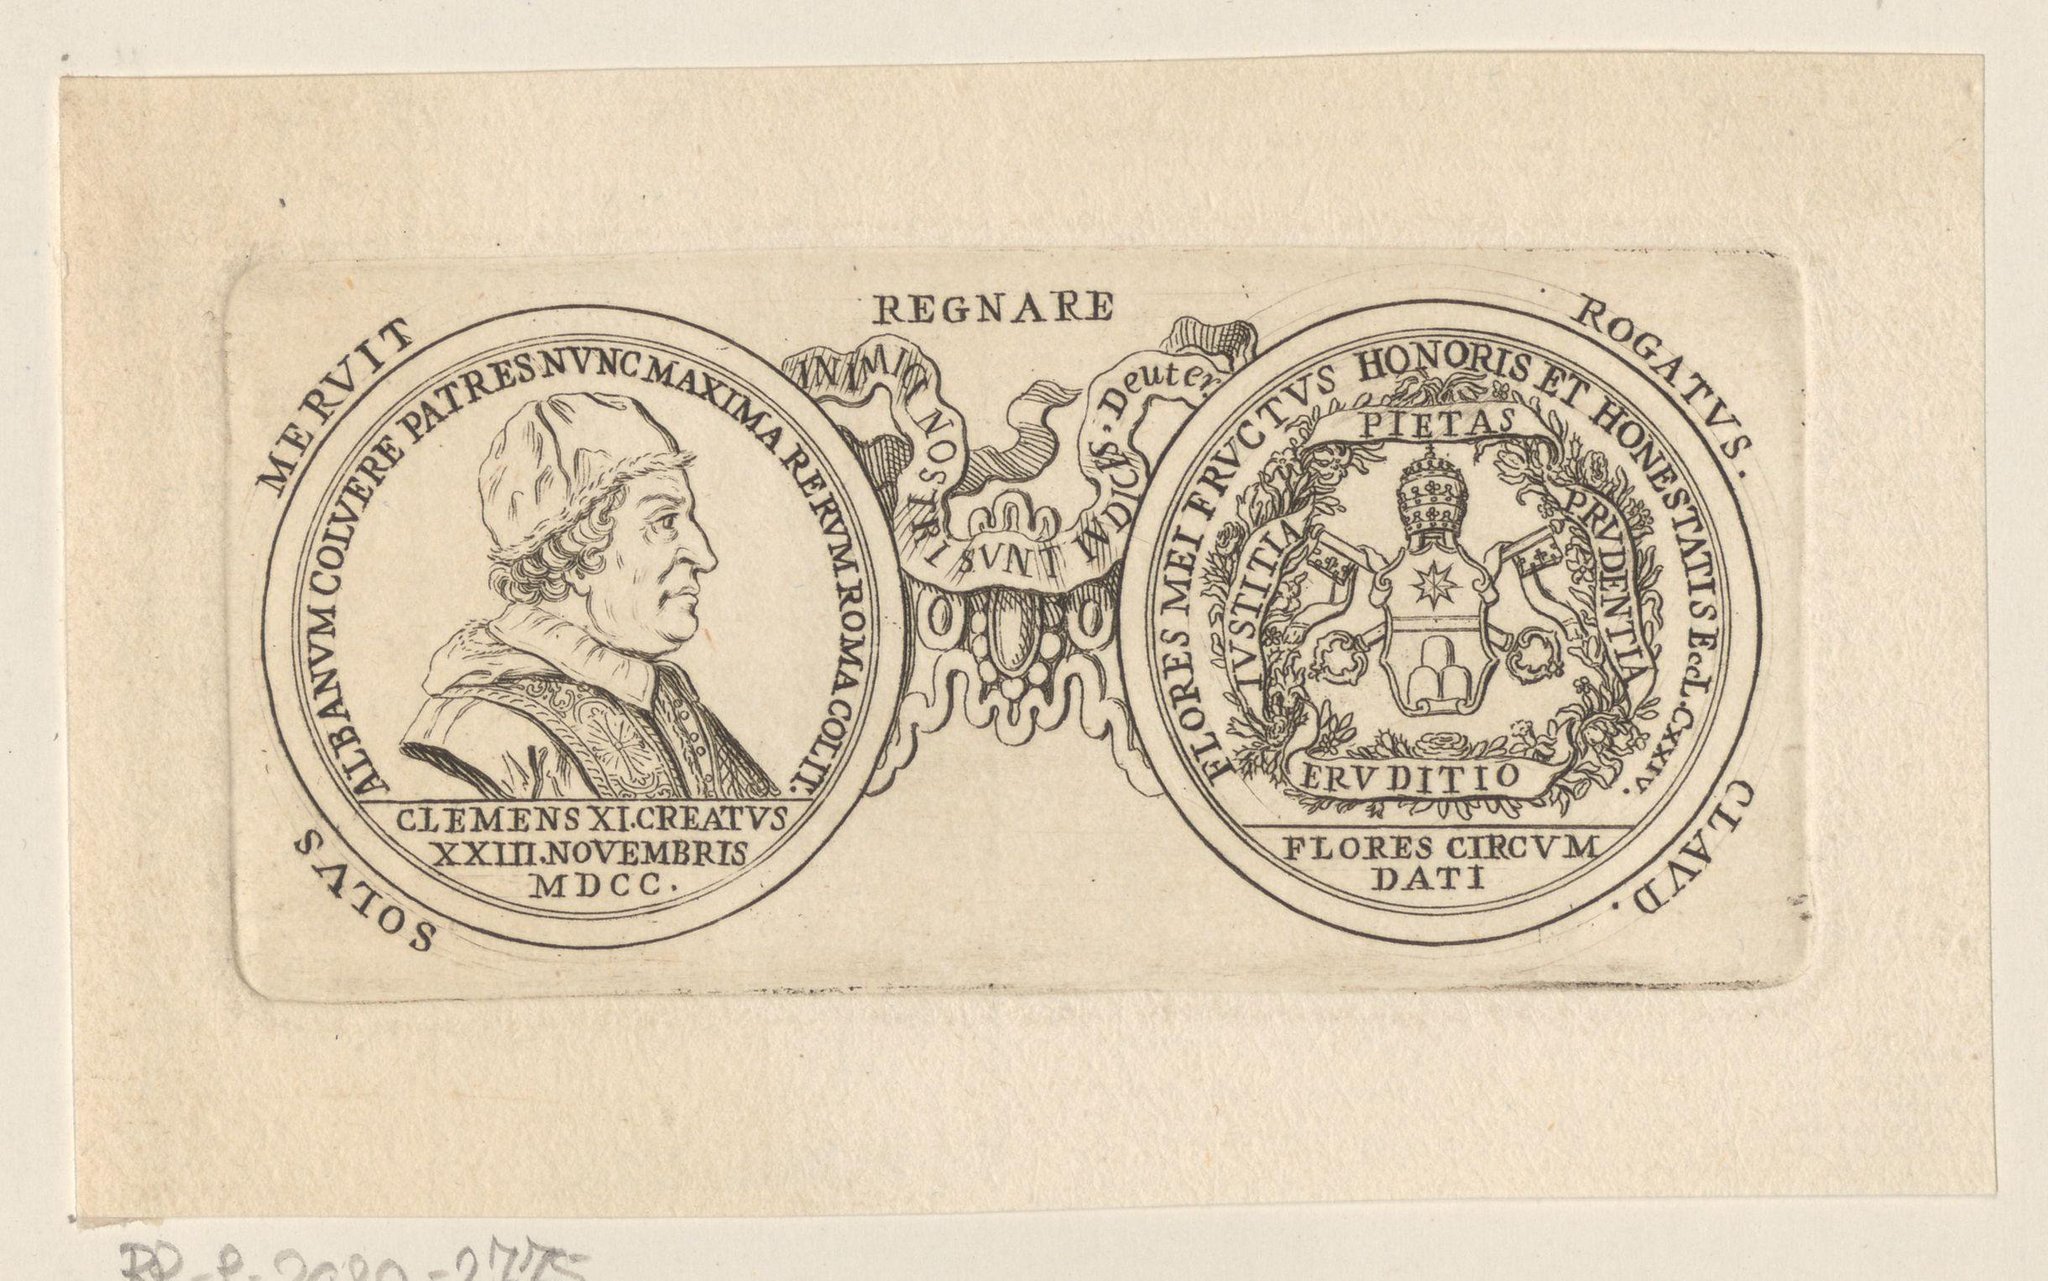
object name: print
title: Medaille met het portret van paus Clemens XI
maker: Anonymous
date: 1700-1749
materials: paper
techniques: engraving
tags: rome, clergyman, clemens xi, historical persons, pope, armorial bearing, heraldry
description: Op de achterkant van de medaille het wapenschild van de geportretteerde.